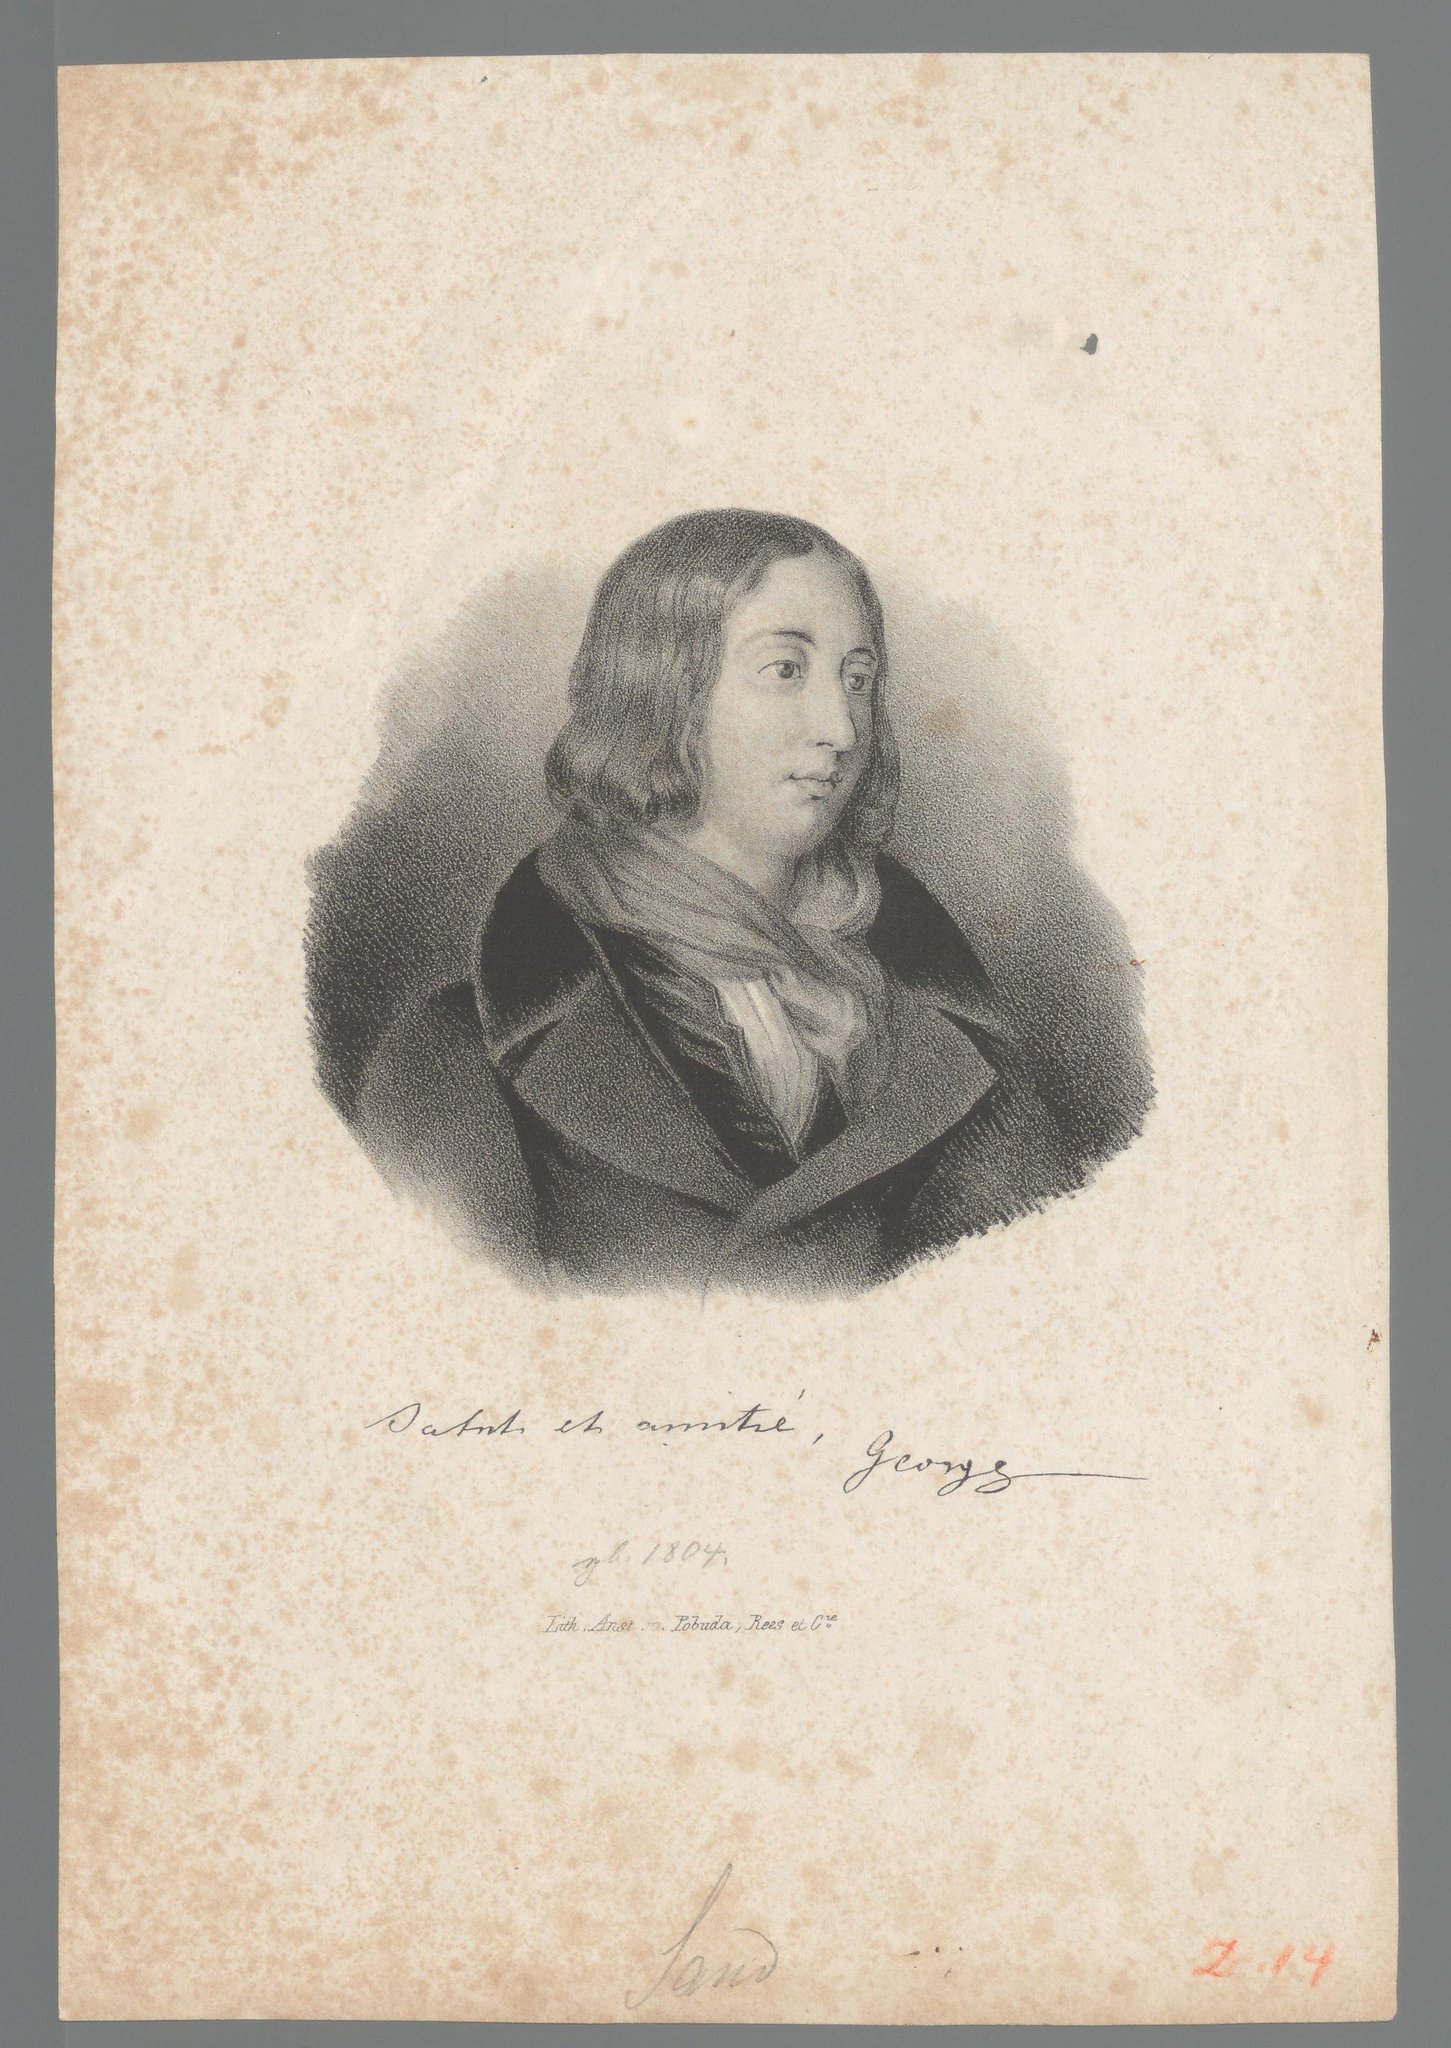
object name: print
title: Portret van George Sand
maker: Anonymous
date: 1820-1875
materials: paper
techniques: lithograph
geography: stuttgart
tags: paris, george sand, adult woman, historical persons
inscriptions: collector's mark: Lugt 2228